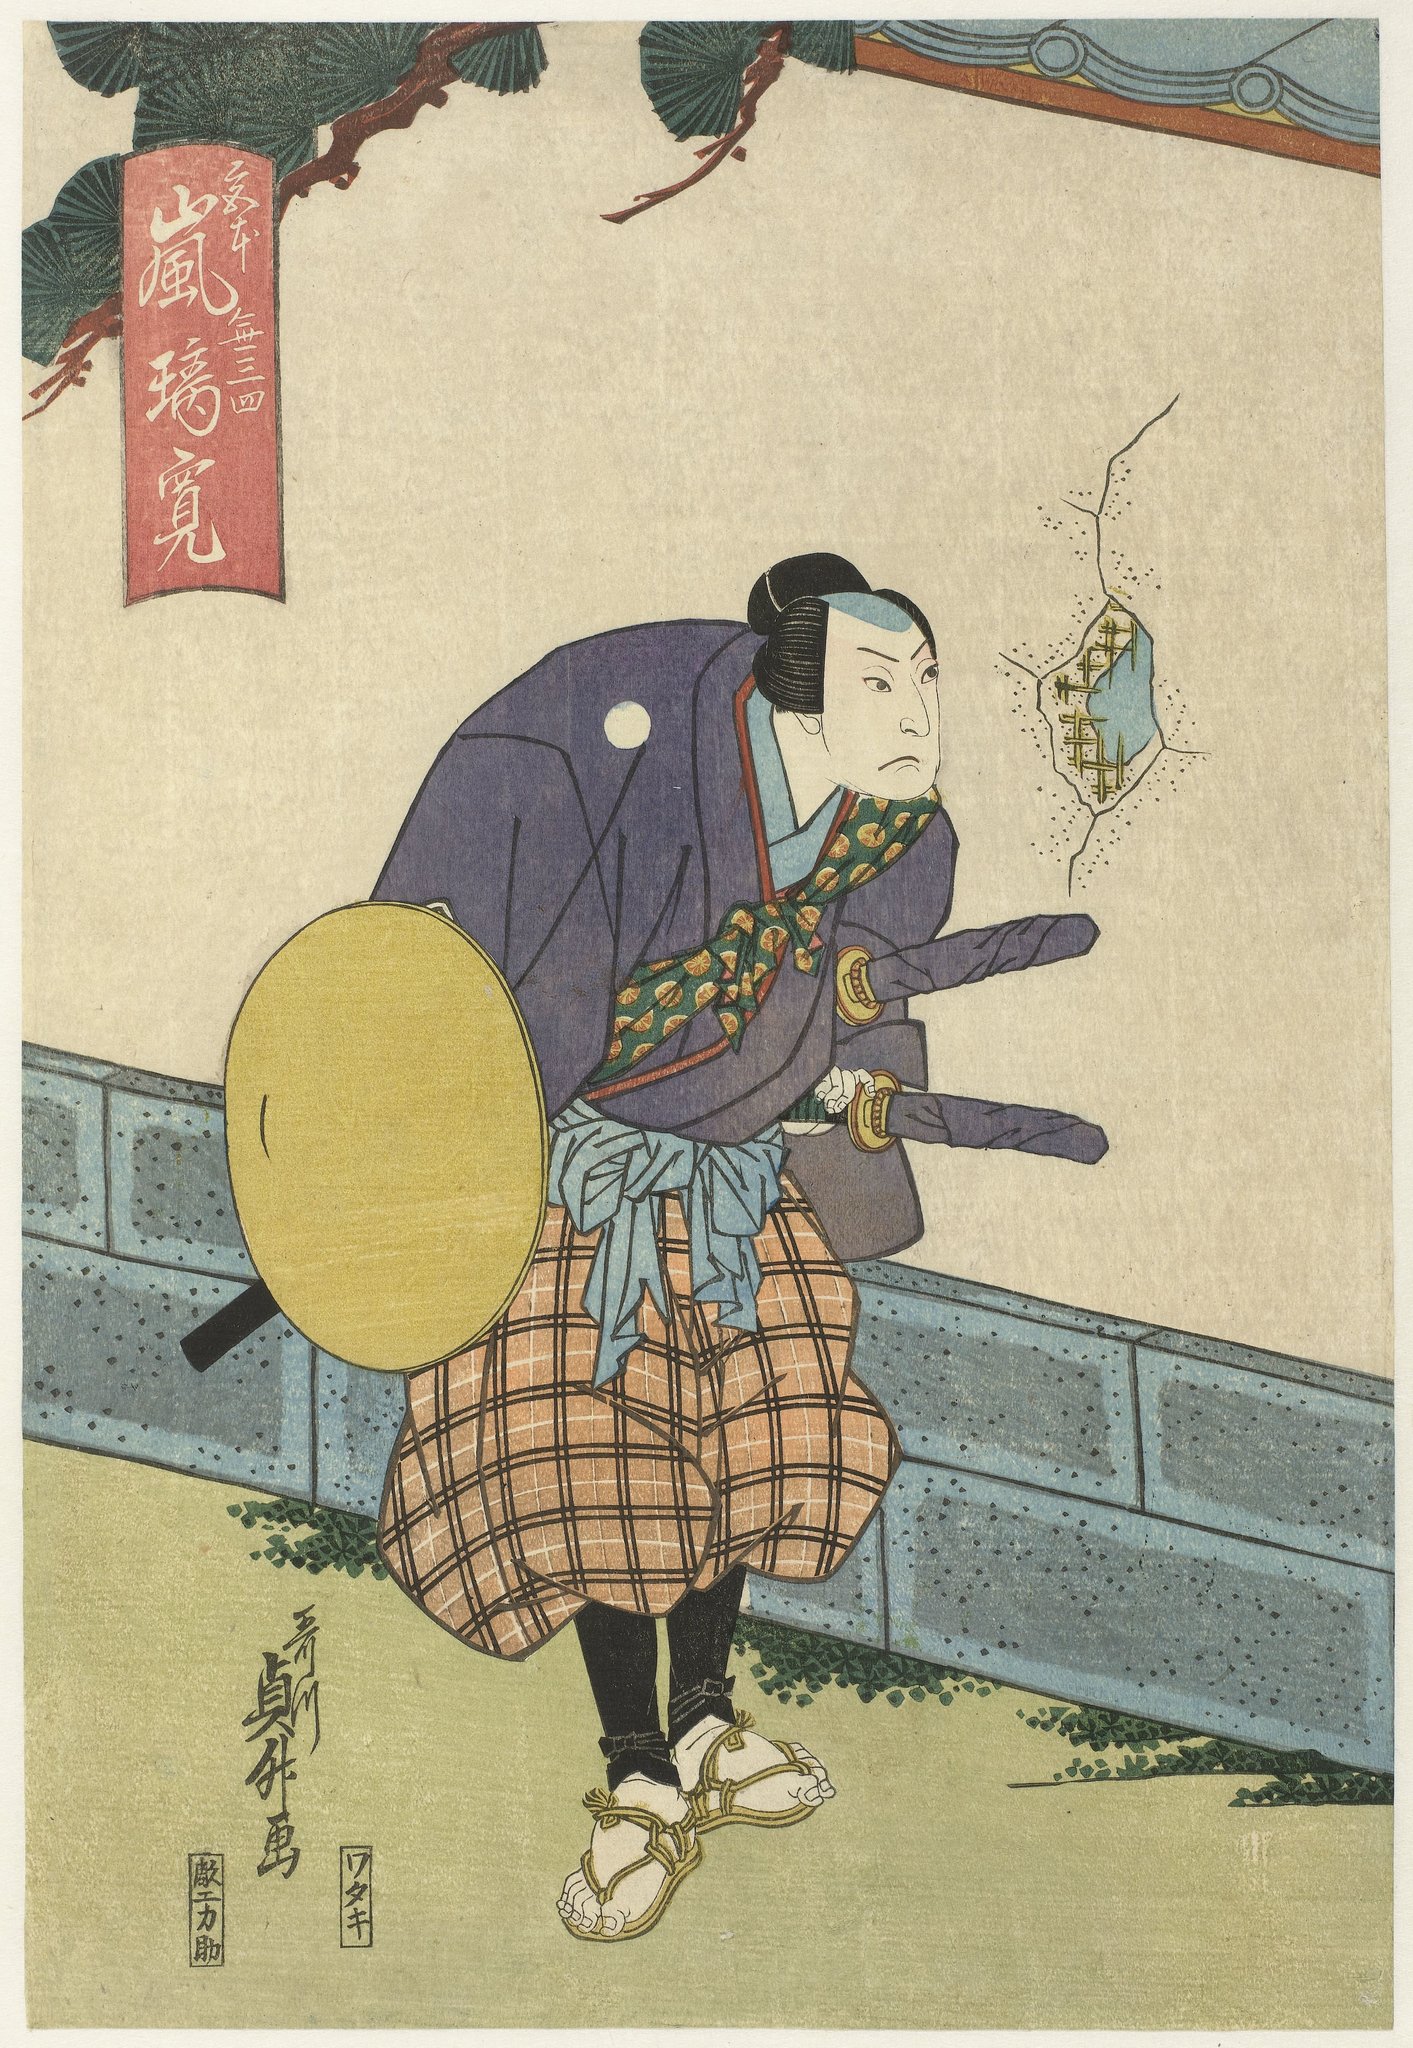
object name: print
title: Samoerai kijkend door gat in een muur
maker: utagawa sadamasu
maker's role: print maker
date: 1832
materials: paper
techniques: woodcut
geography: osaka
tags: protective weapons: shield, fence, wall, paling, actor (on the stage)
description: Toneelspeler Arashi Rikan III, in de rol van samoerai Miyamoto Musashi, kijkt door een gat in de muur. Scene uit het toneelstuk "Katakiuchi nitô eiyûki", opgevoerd in het Chikugo (Ônishi) Theater, in de eerste maand van 1832.